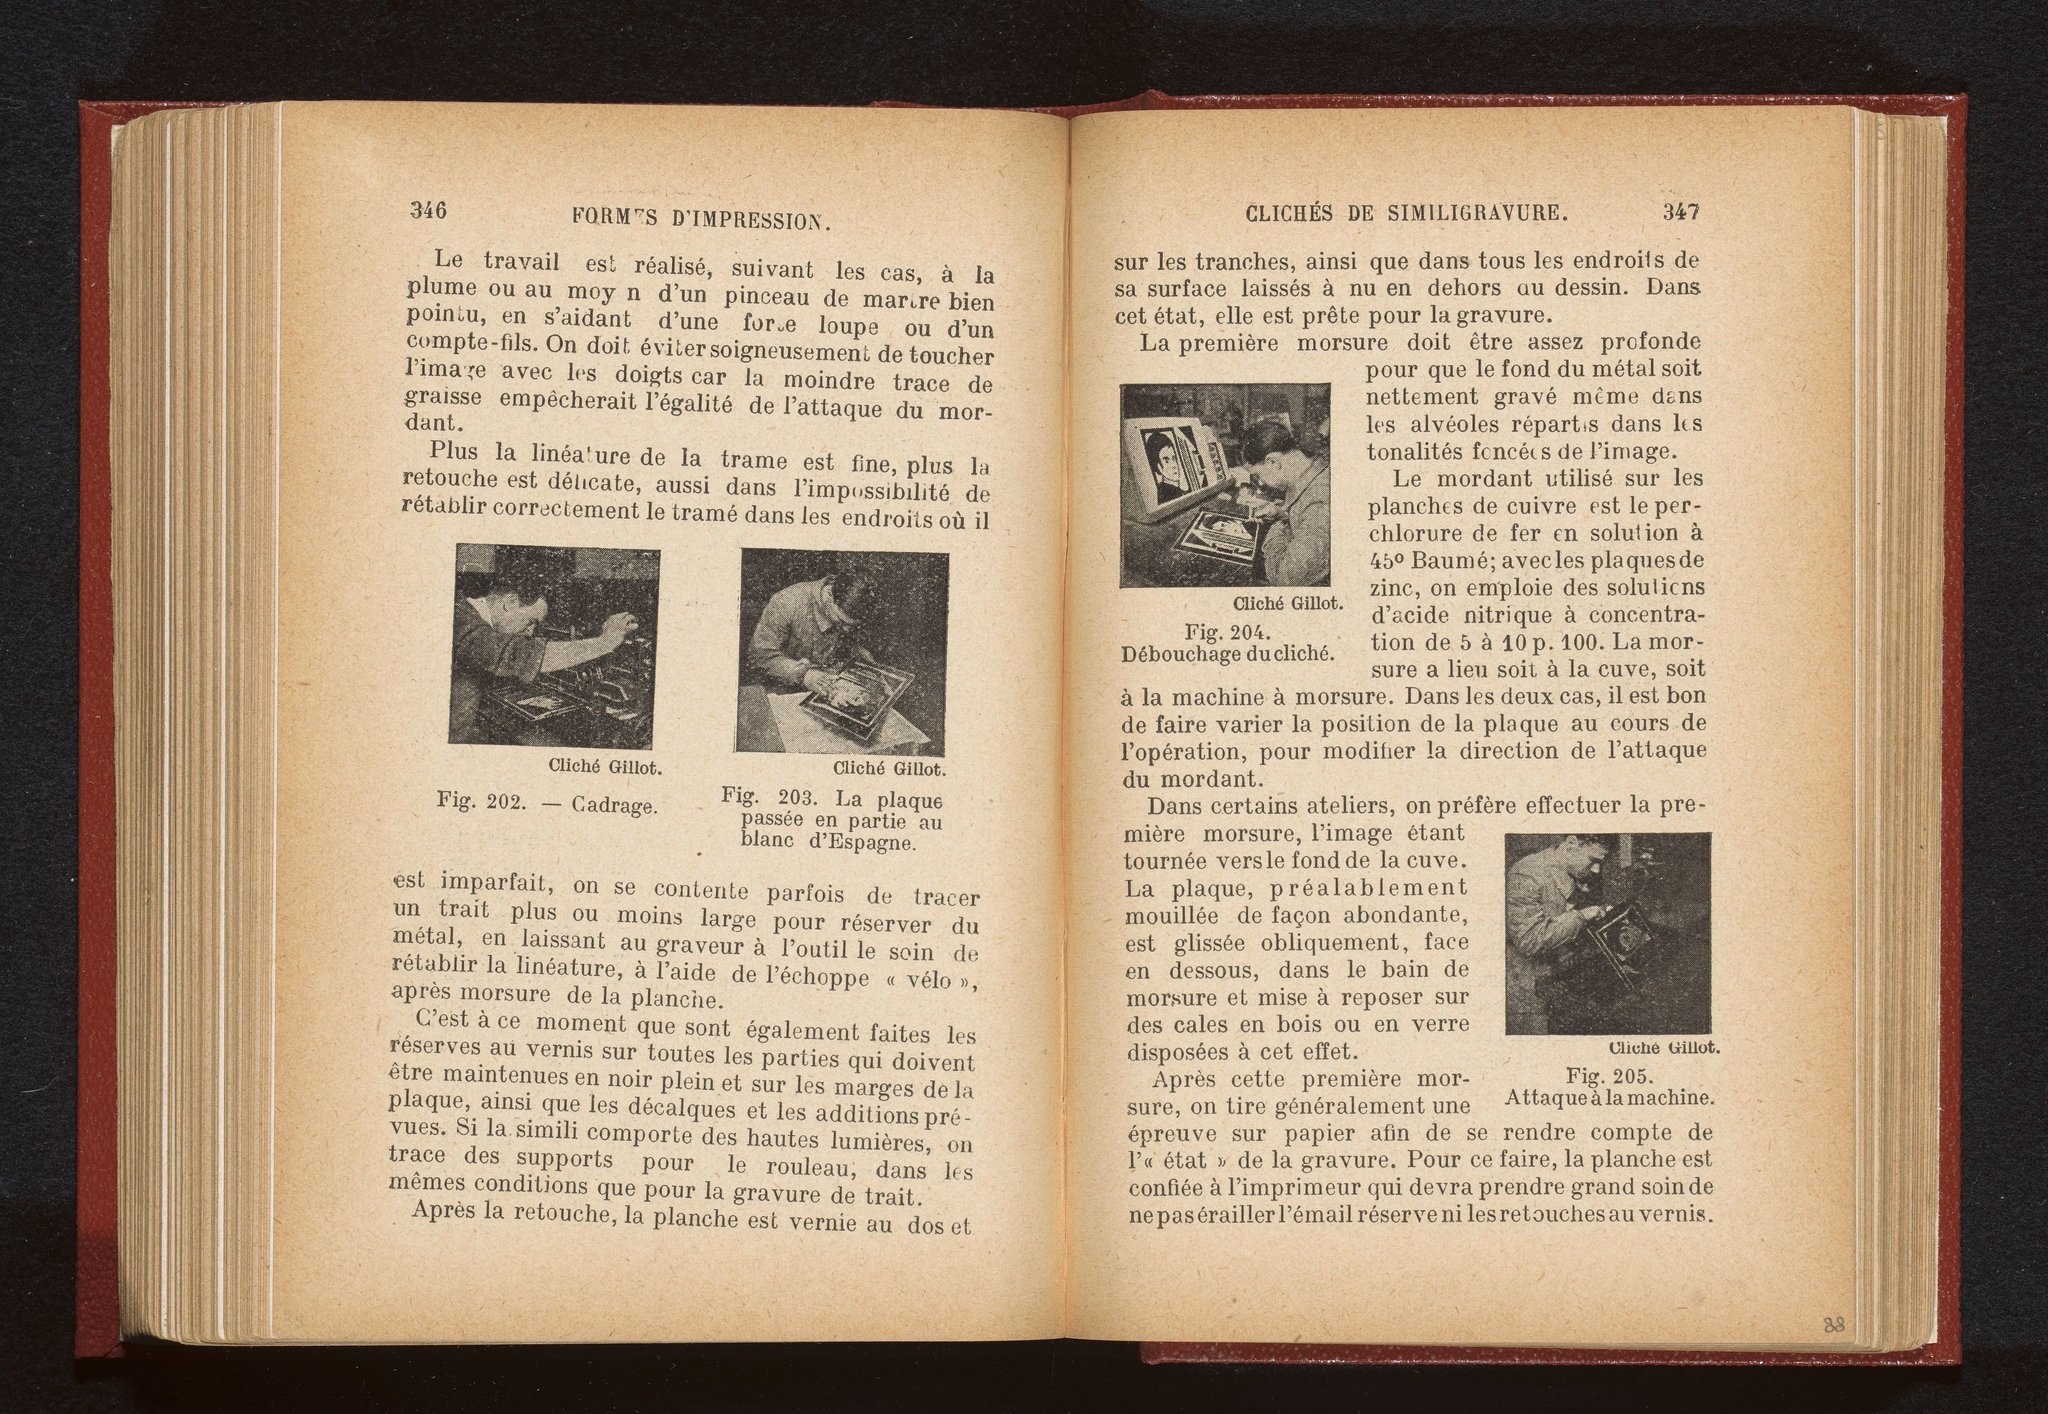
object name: photomechanical print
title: Cadrage. La plaque passée en partie au blanc d'Espagne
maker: Anonymous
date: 1922-1932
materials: paper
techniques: autotype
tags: print, e.g.: engraving, etching, lithograph, photographic apparatus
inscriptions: number: ‘Fig. 202. Fig. 203.’